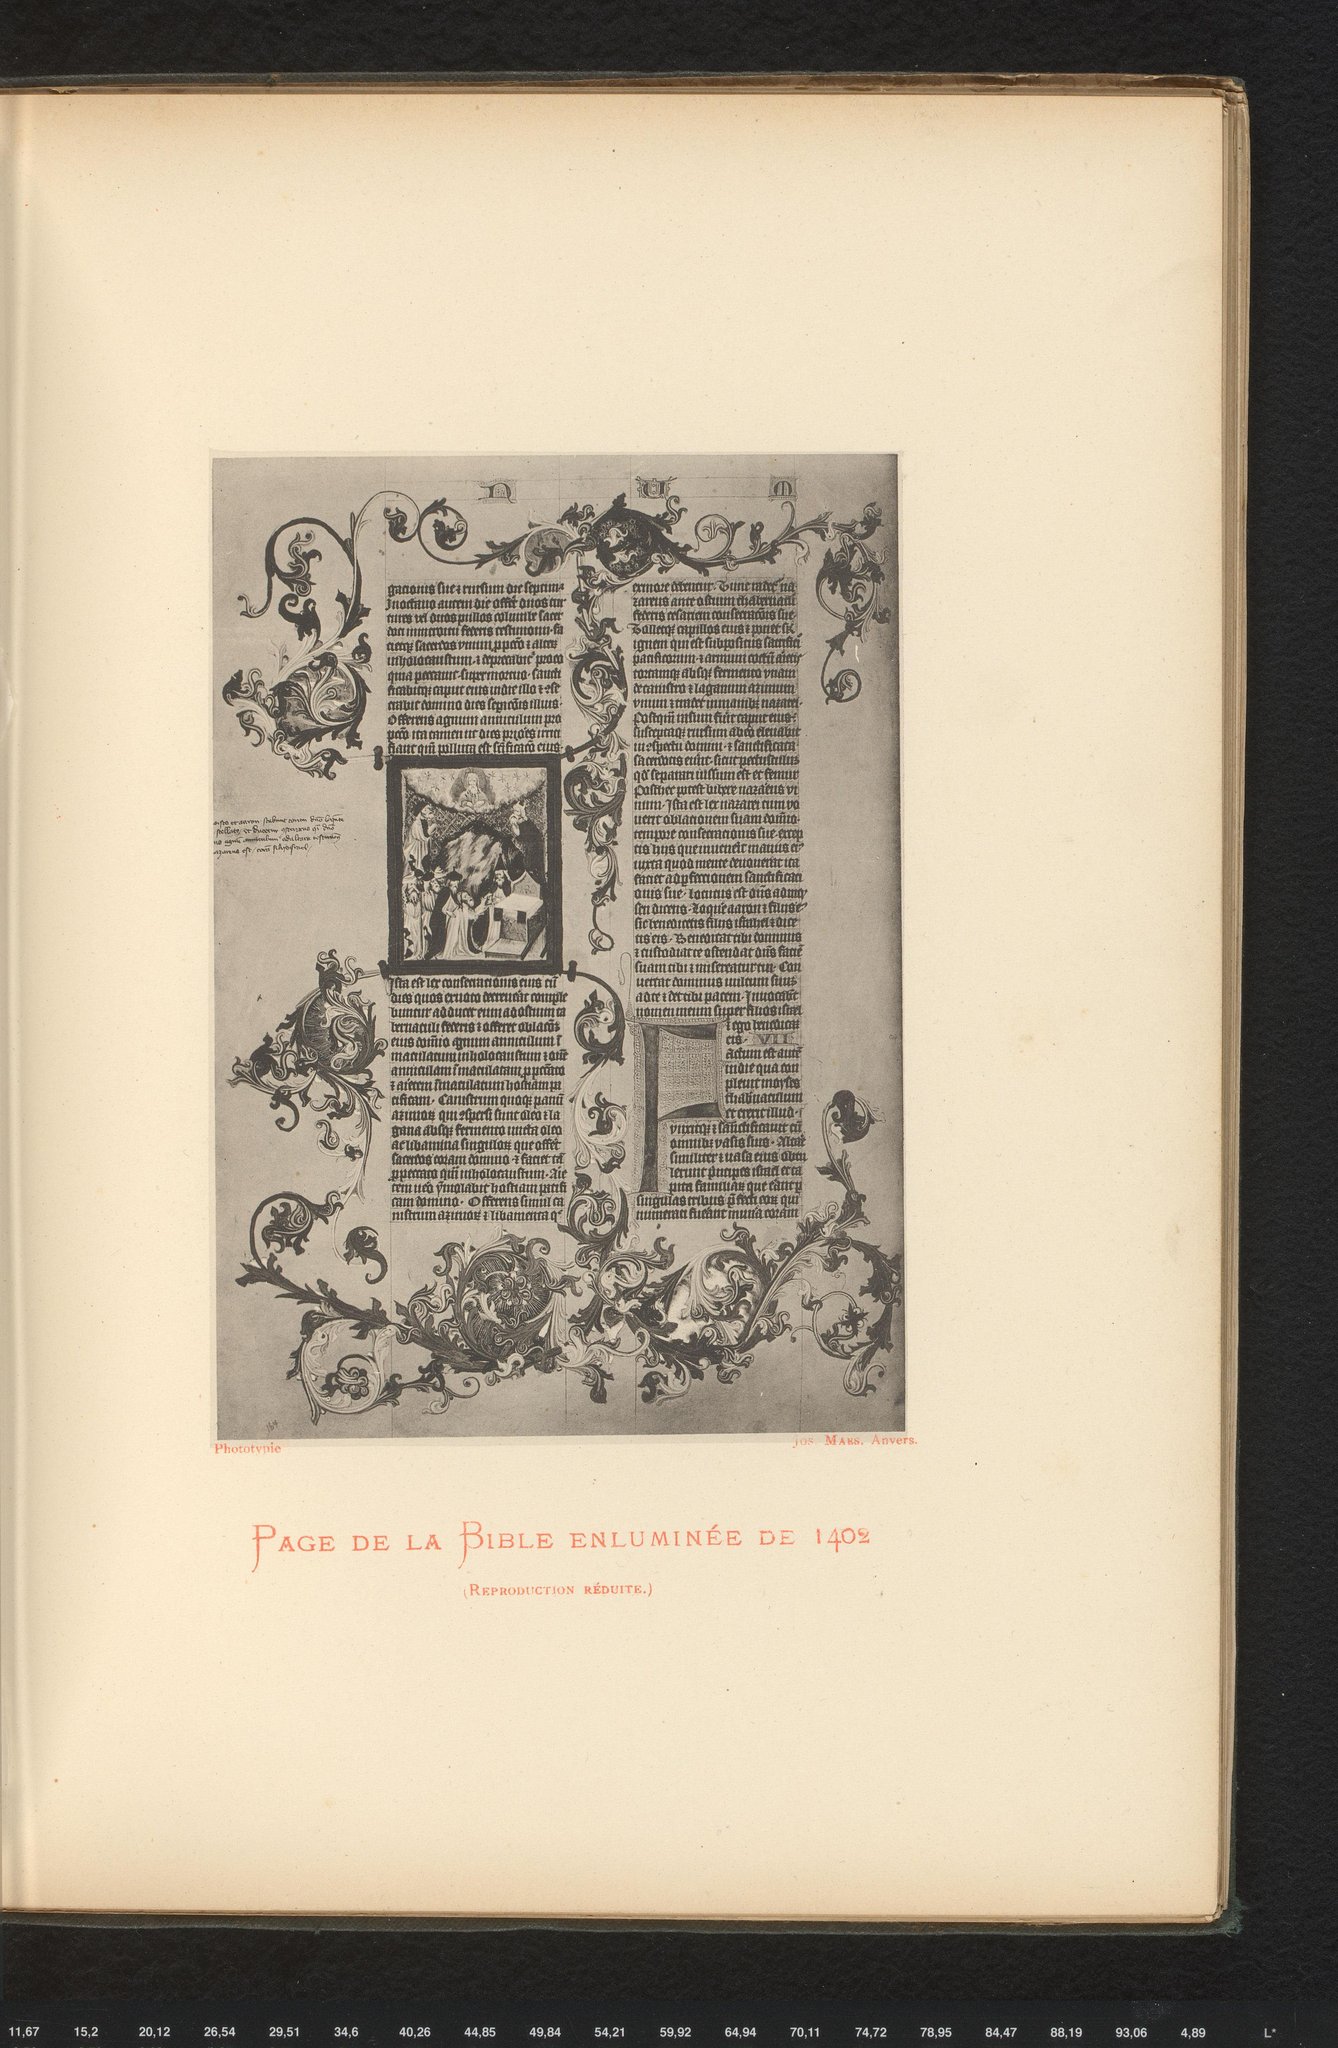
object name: photomechanical print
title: Page de la Bible enluminée de 1402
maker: joseph maes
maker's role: fotograaf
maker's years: 1838-1908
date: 1877-1882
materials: paper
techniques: photograph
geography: antwerp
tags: bible